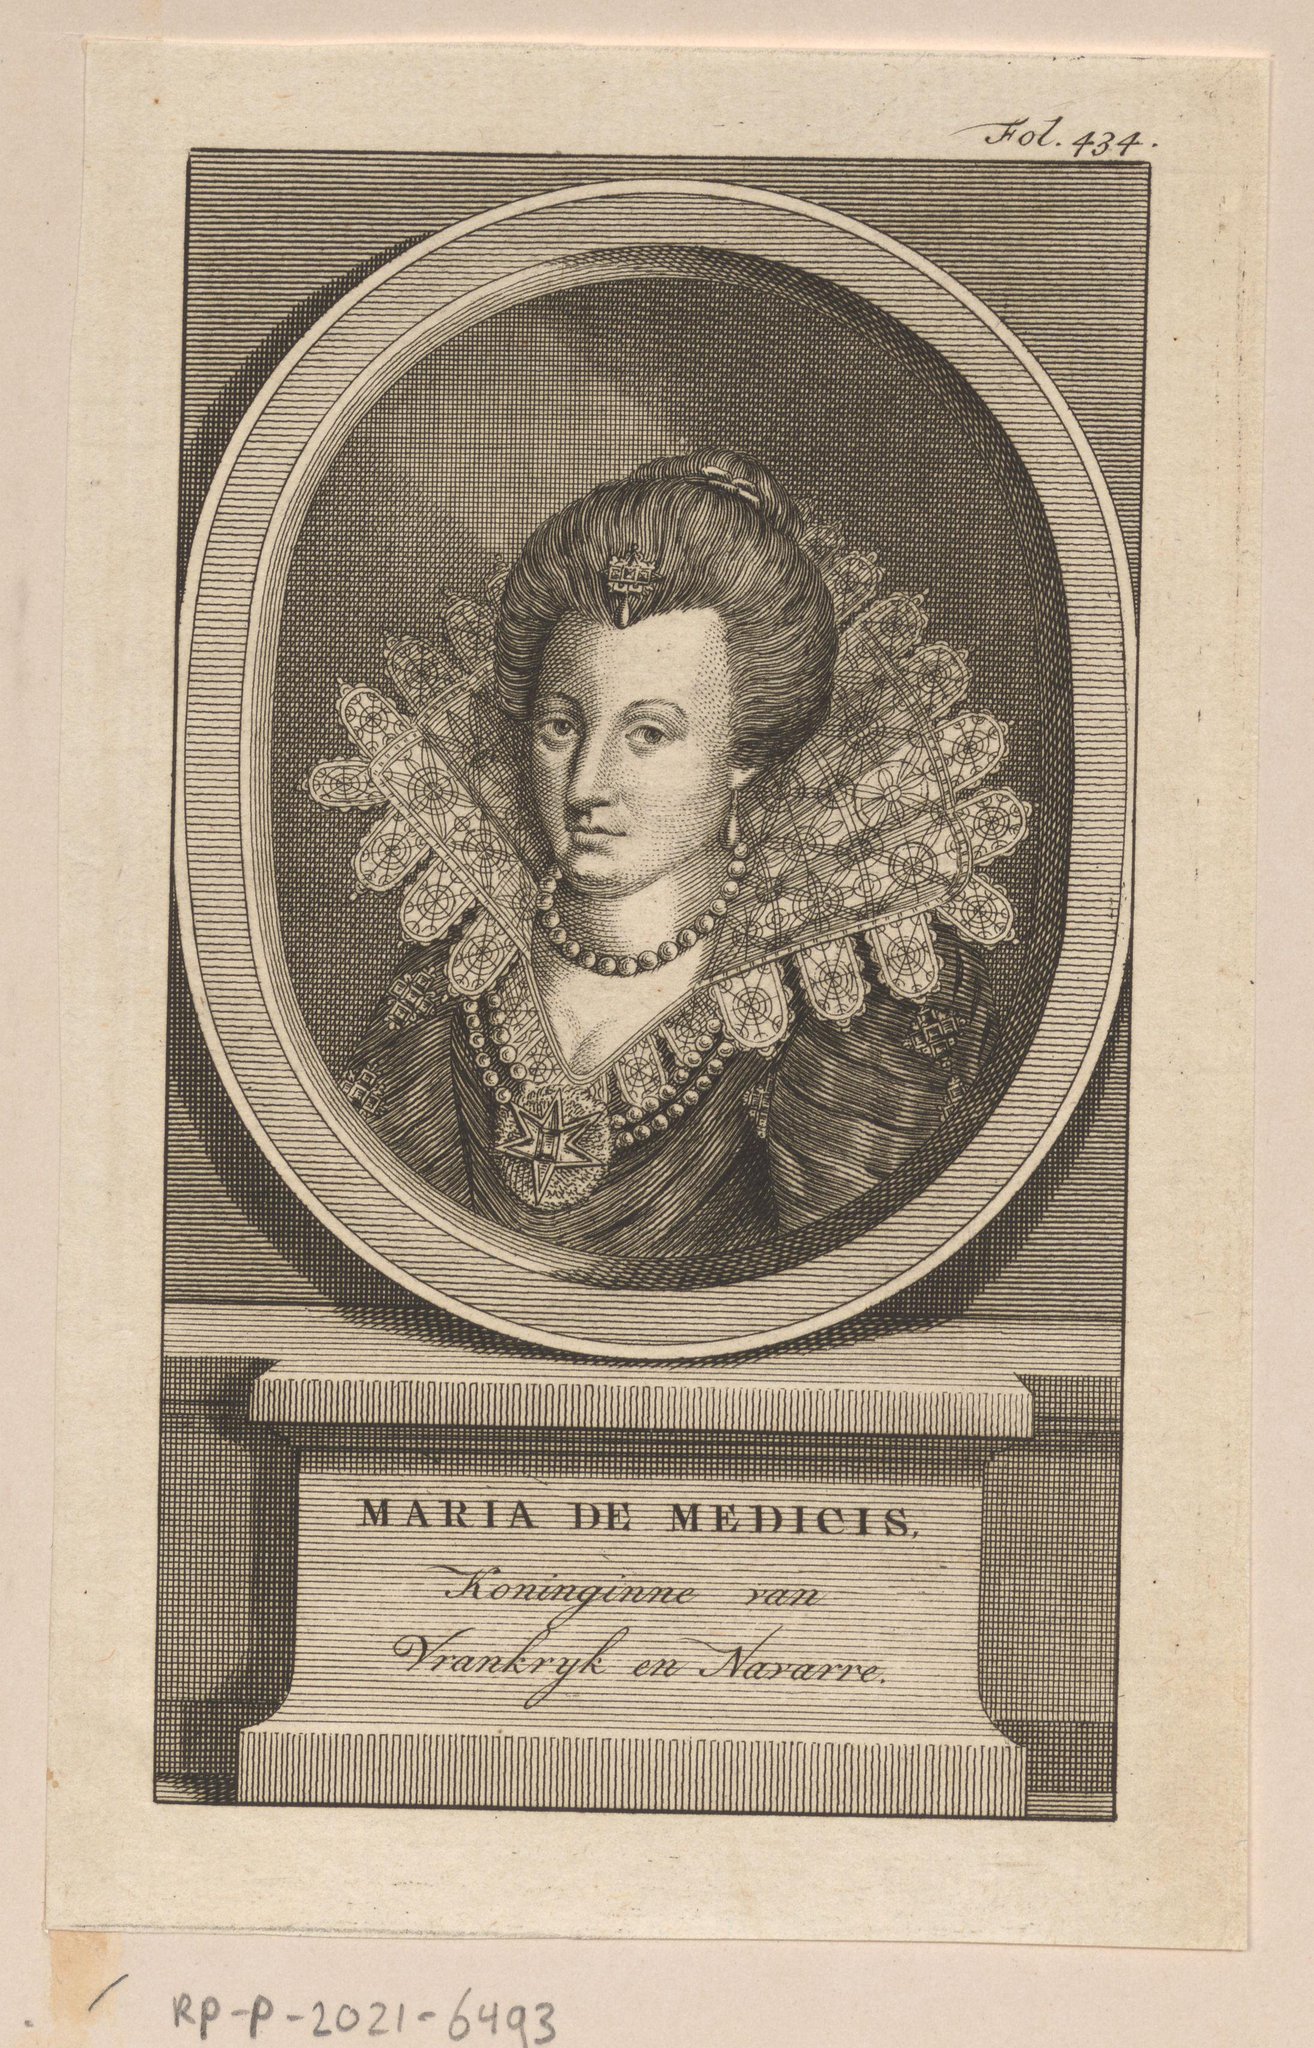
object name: book illustration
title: Portret van Maria de' Medici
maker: Anonymous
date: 1650-1750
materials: paper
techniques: etching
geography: northern netherlands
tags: cologne, maria de' medici, historical persons - bb - woman, ornament ~ medallion, queen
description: Prent komt uit een onbekende publicatie.